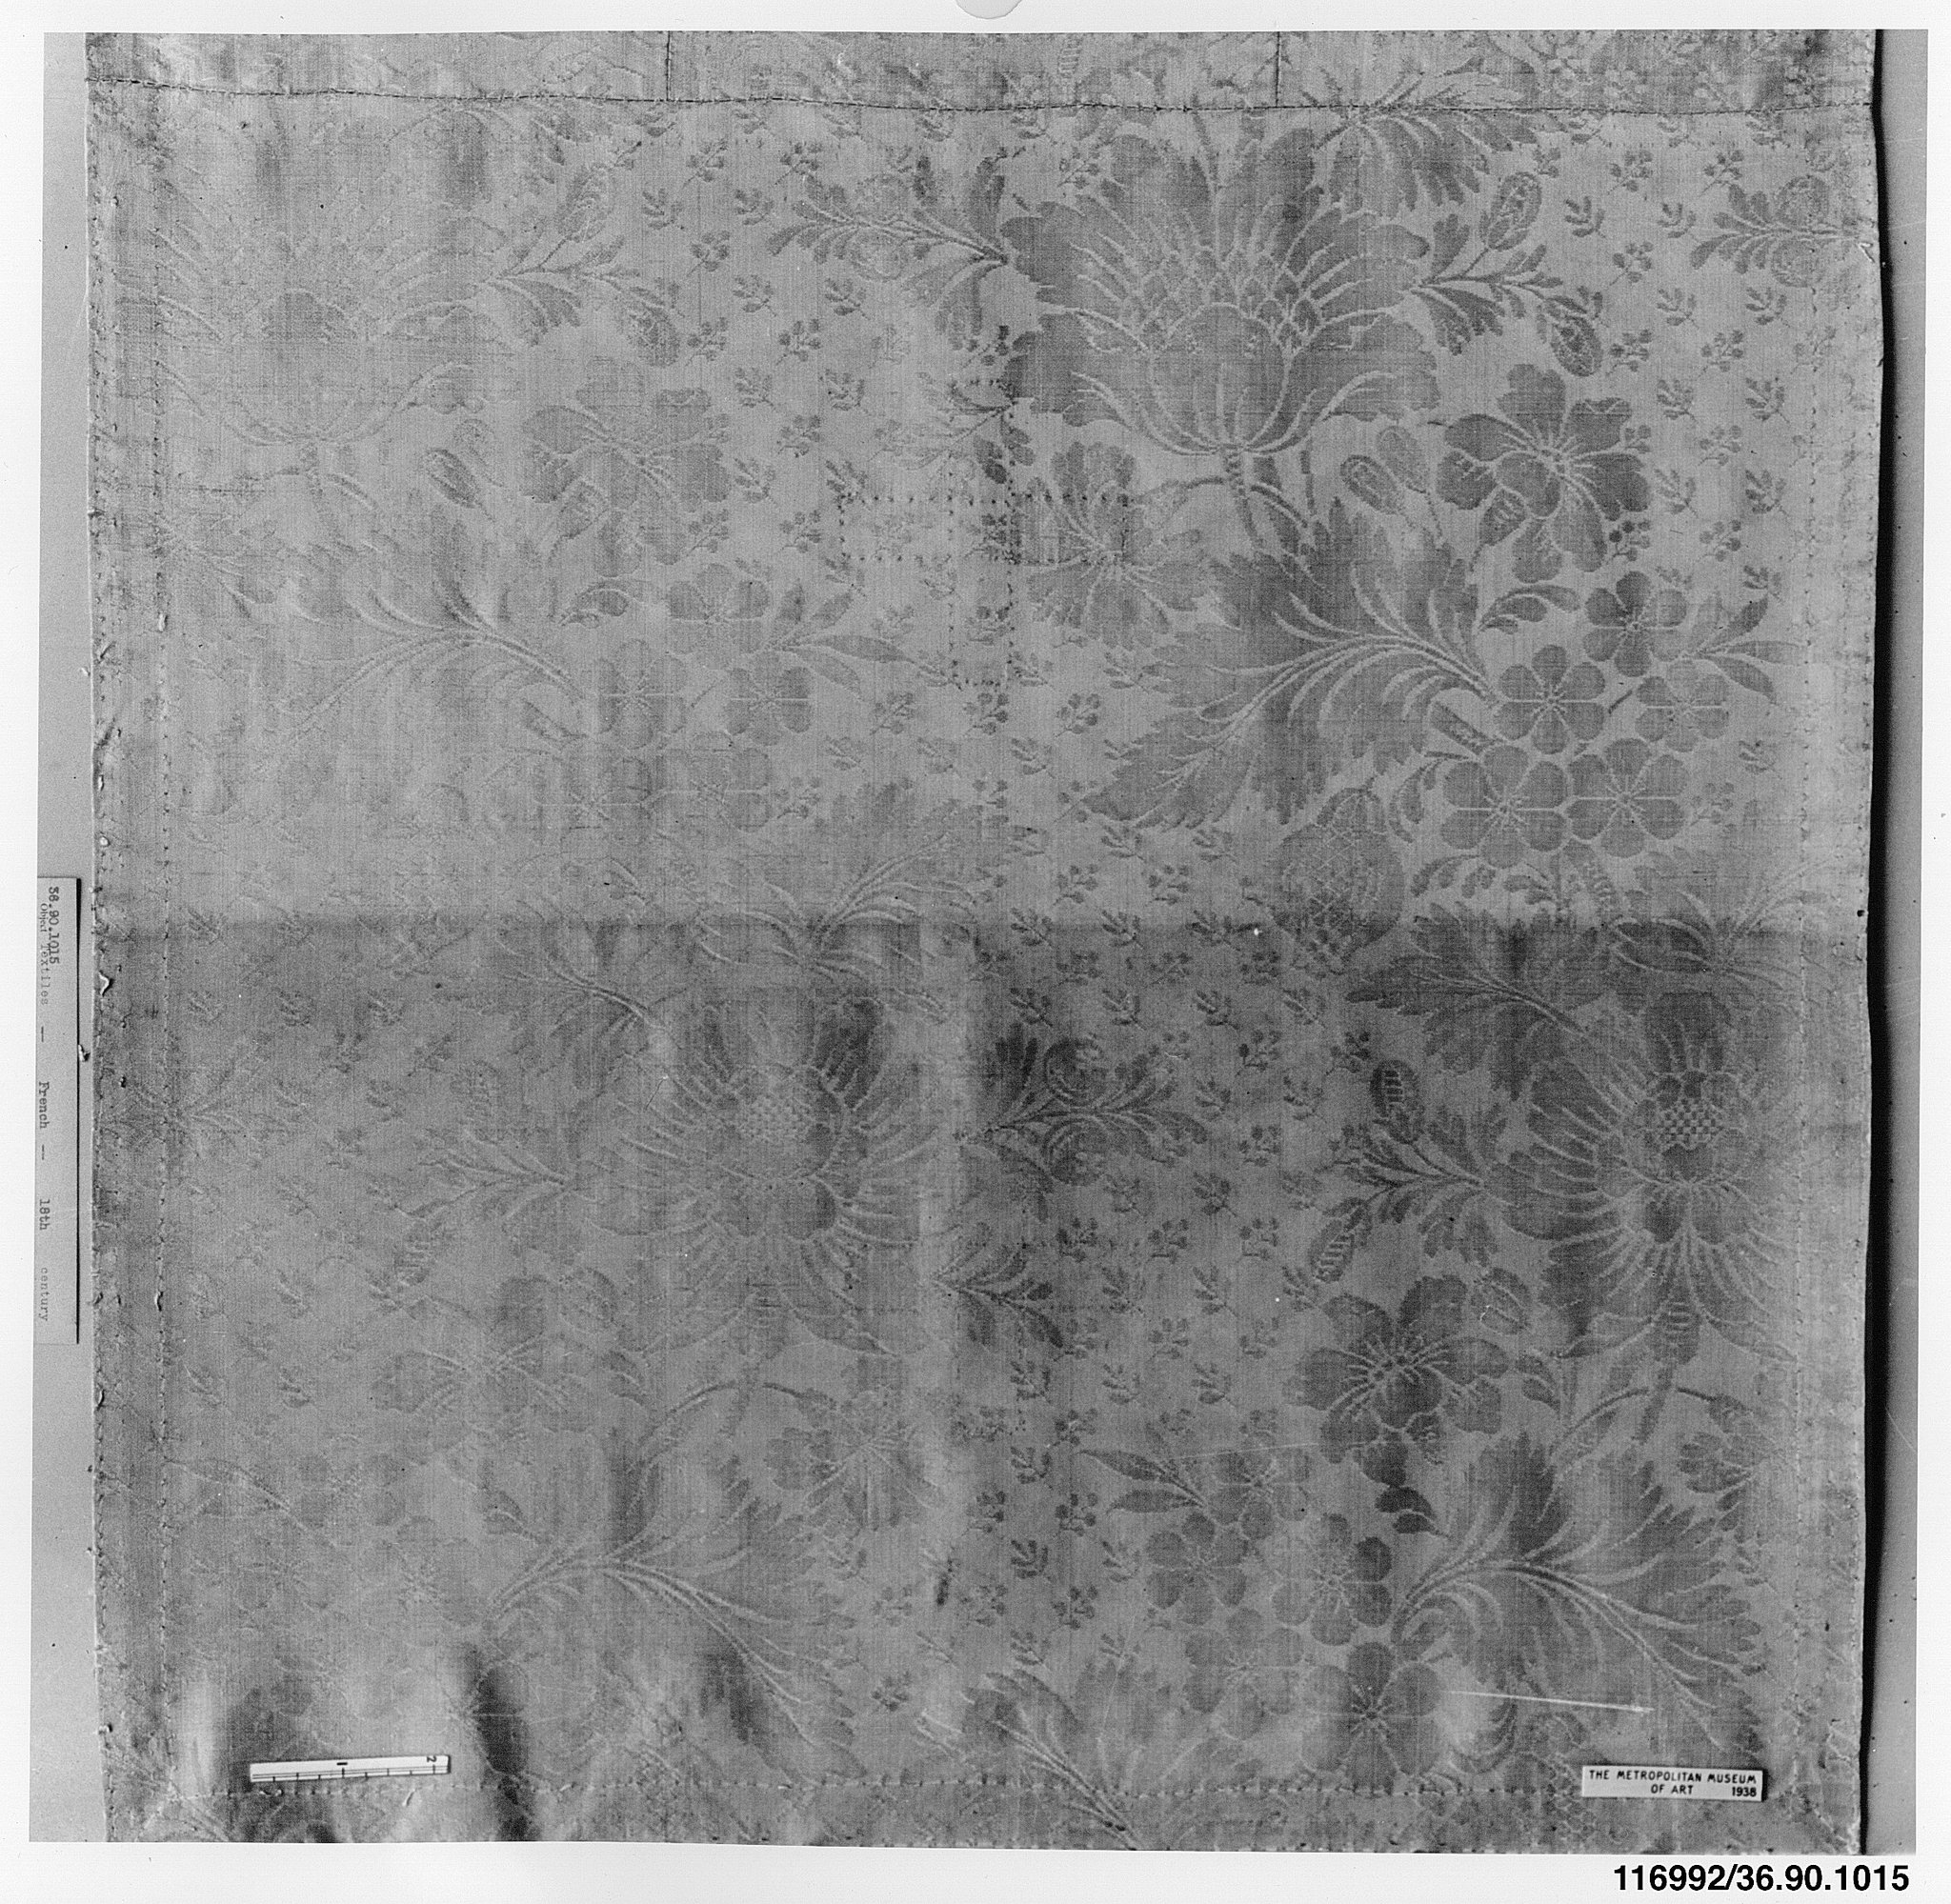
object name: piece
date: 1801-1900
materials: silk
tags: flowers,leaves